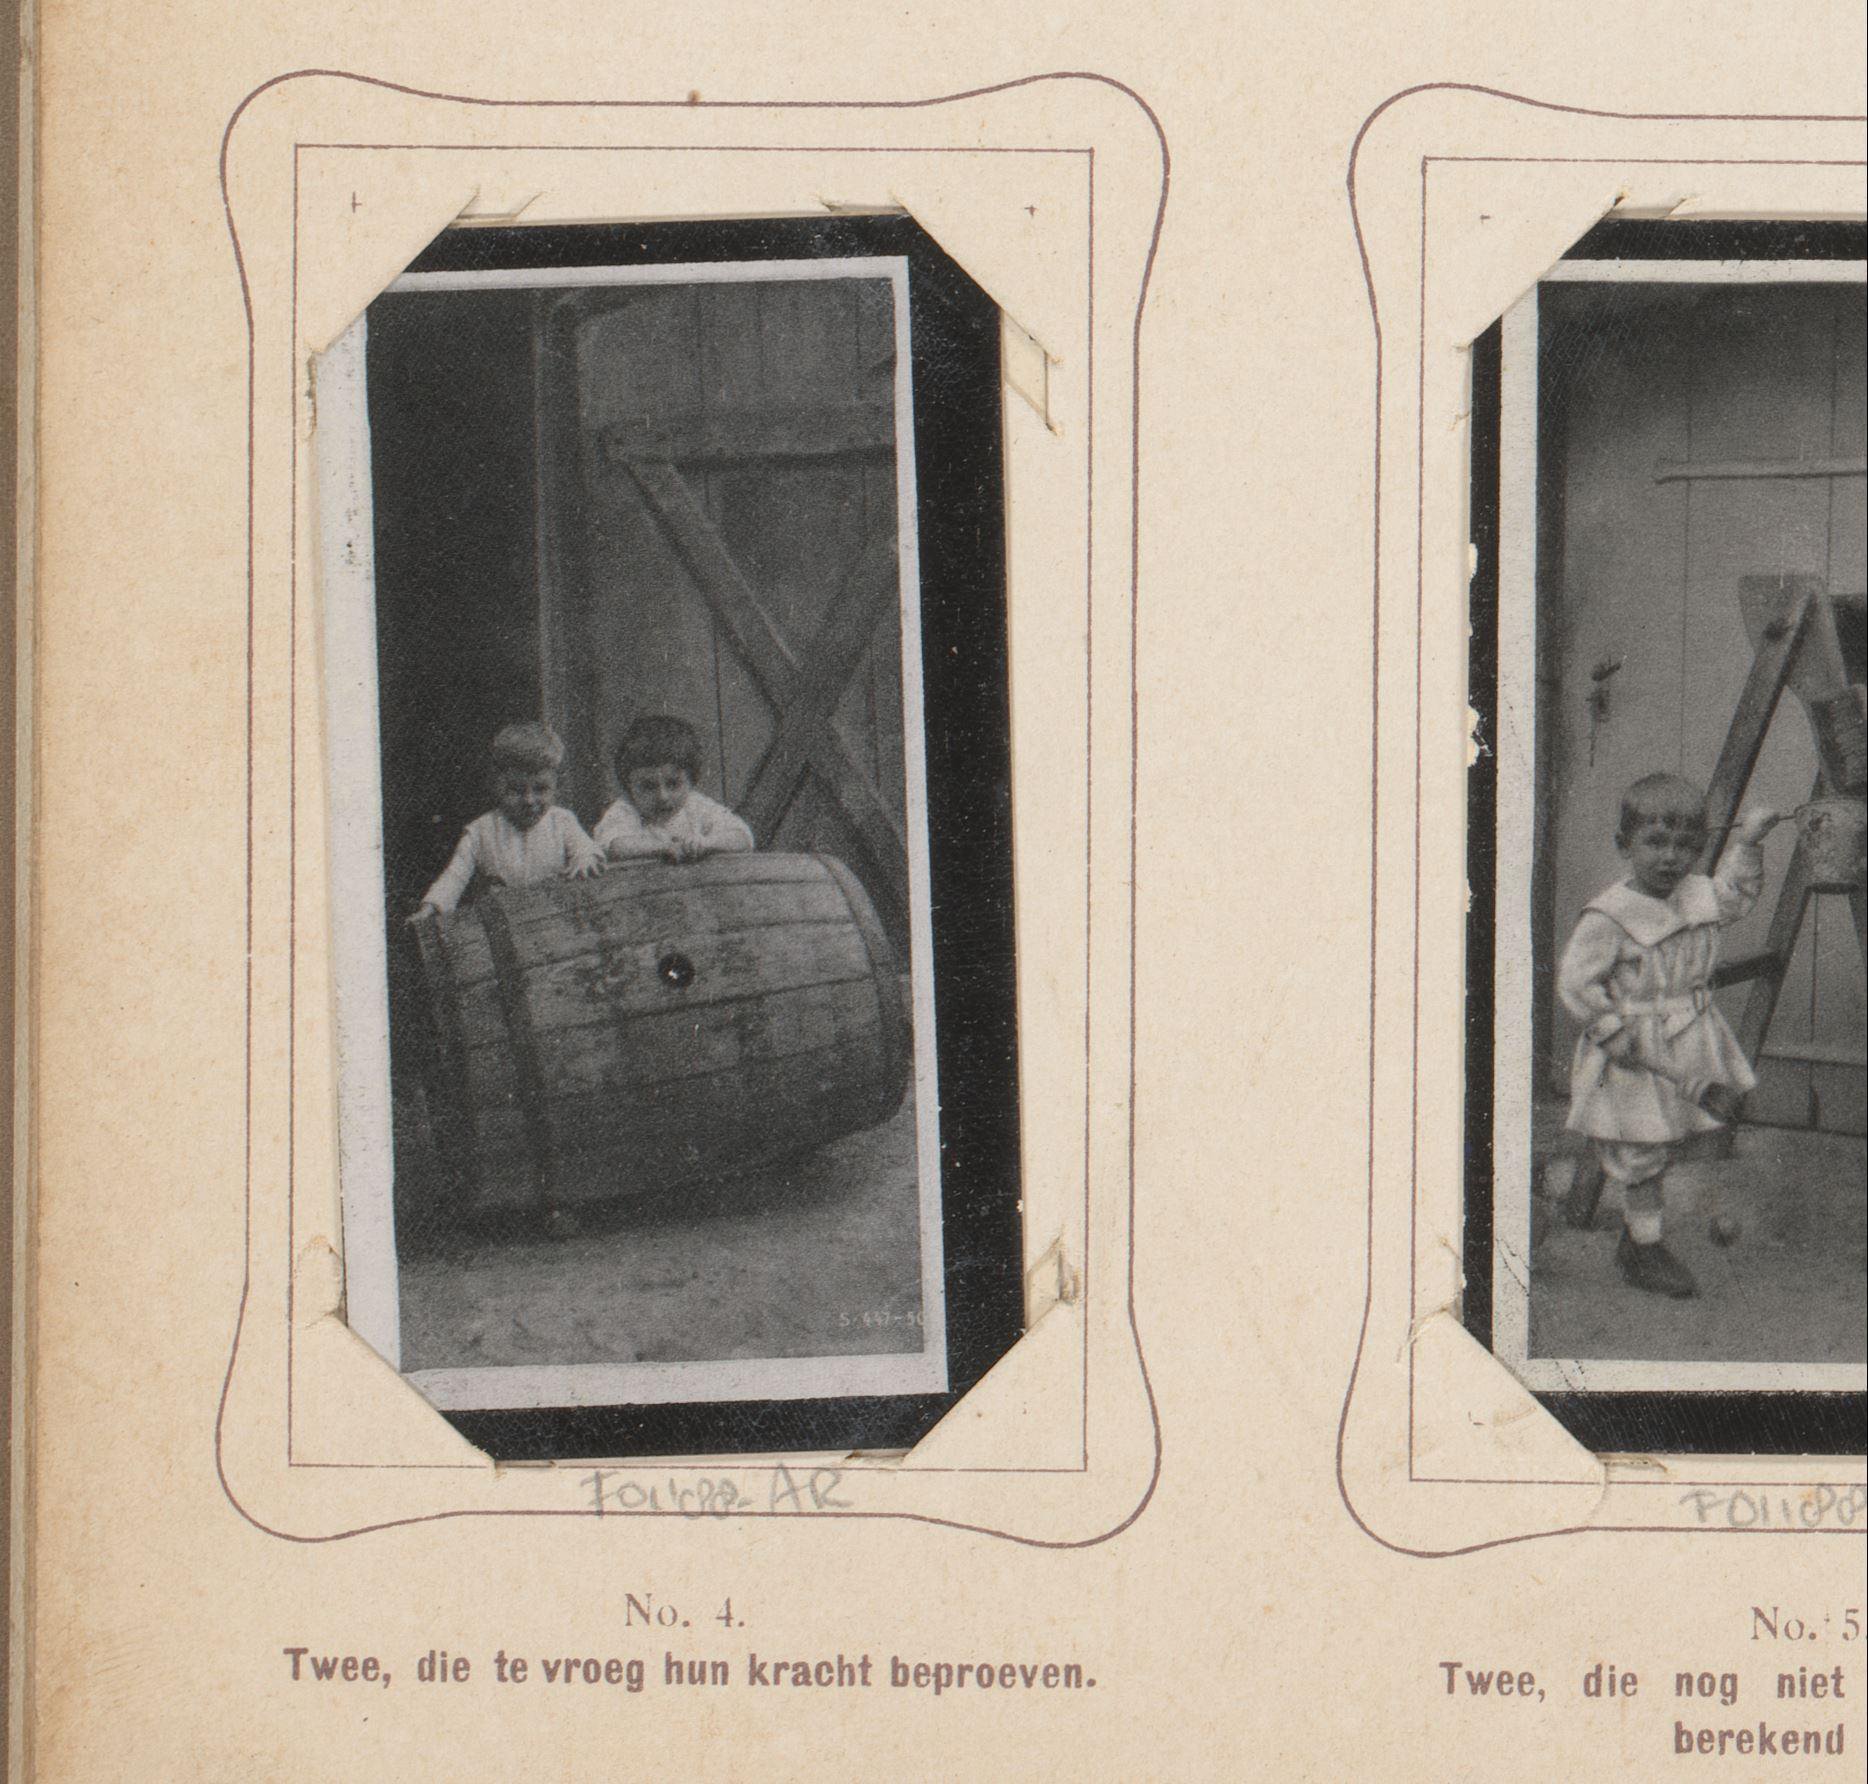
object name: photomechanical print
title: Twee kinderen duwen een vat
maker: Anonymous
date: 1906-1907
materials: paper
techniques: photograph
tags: wooden container: barrel, cask, bucket, child, playing toddler; child amusing itself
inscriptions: inscription: ‘No. 4./ Twee, die te vroeg hun kracht beproeven.’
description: Deze prent maakt deel uit van een album.